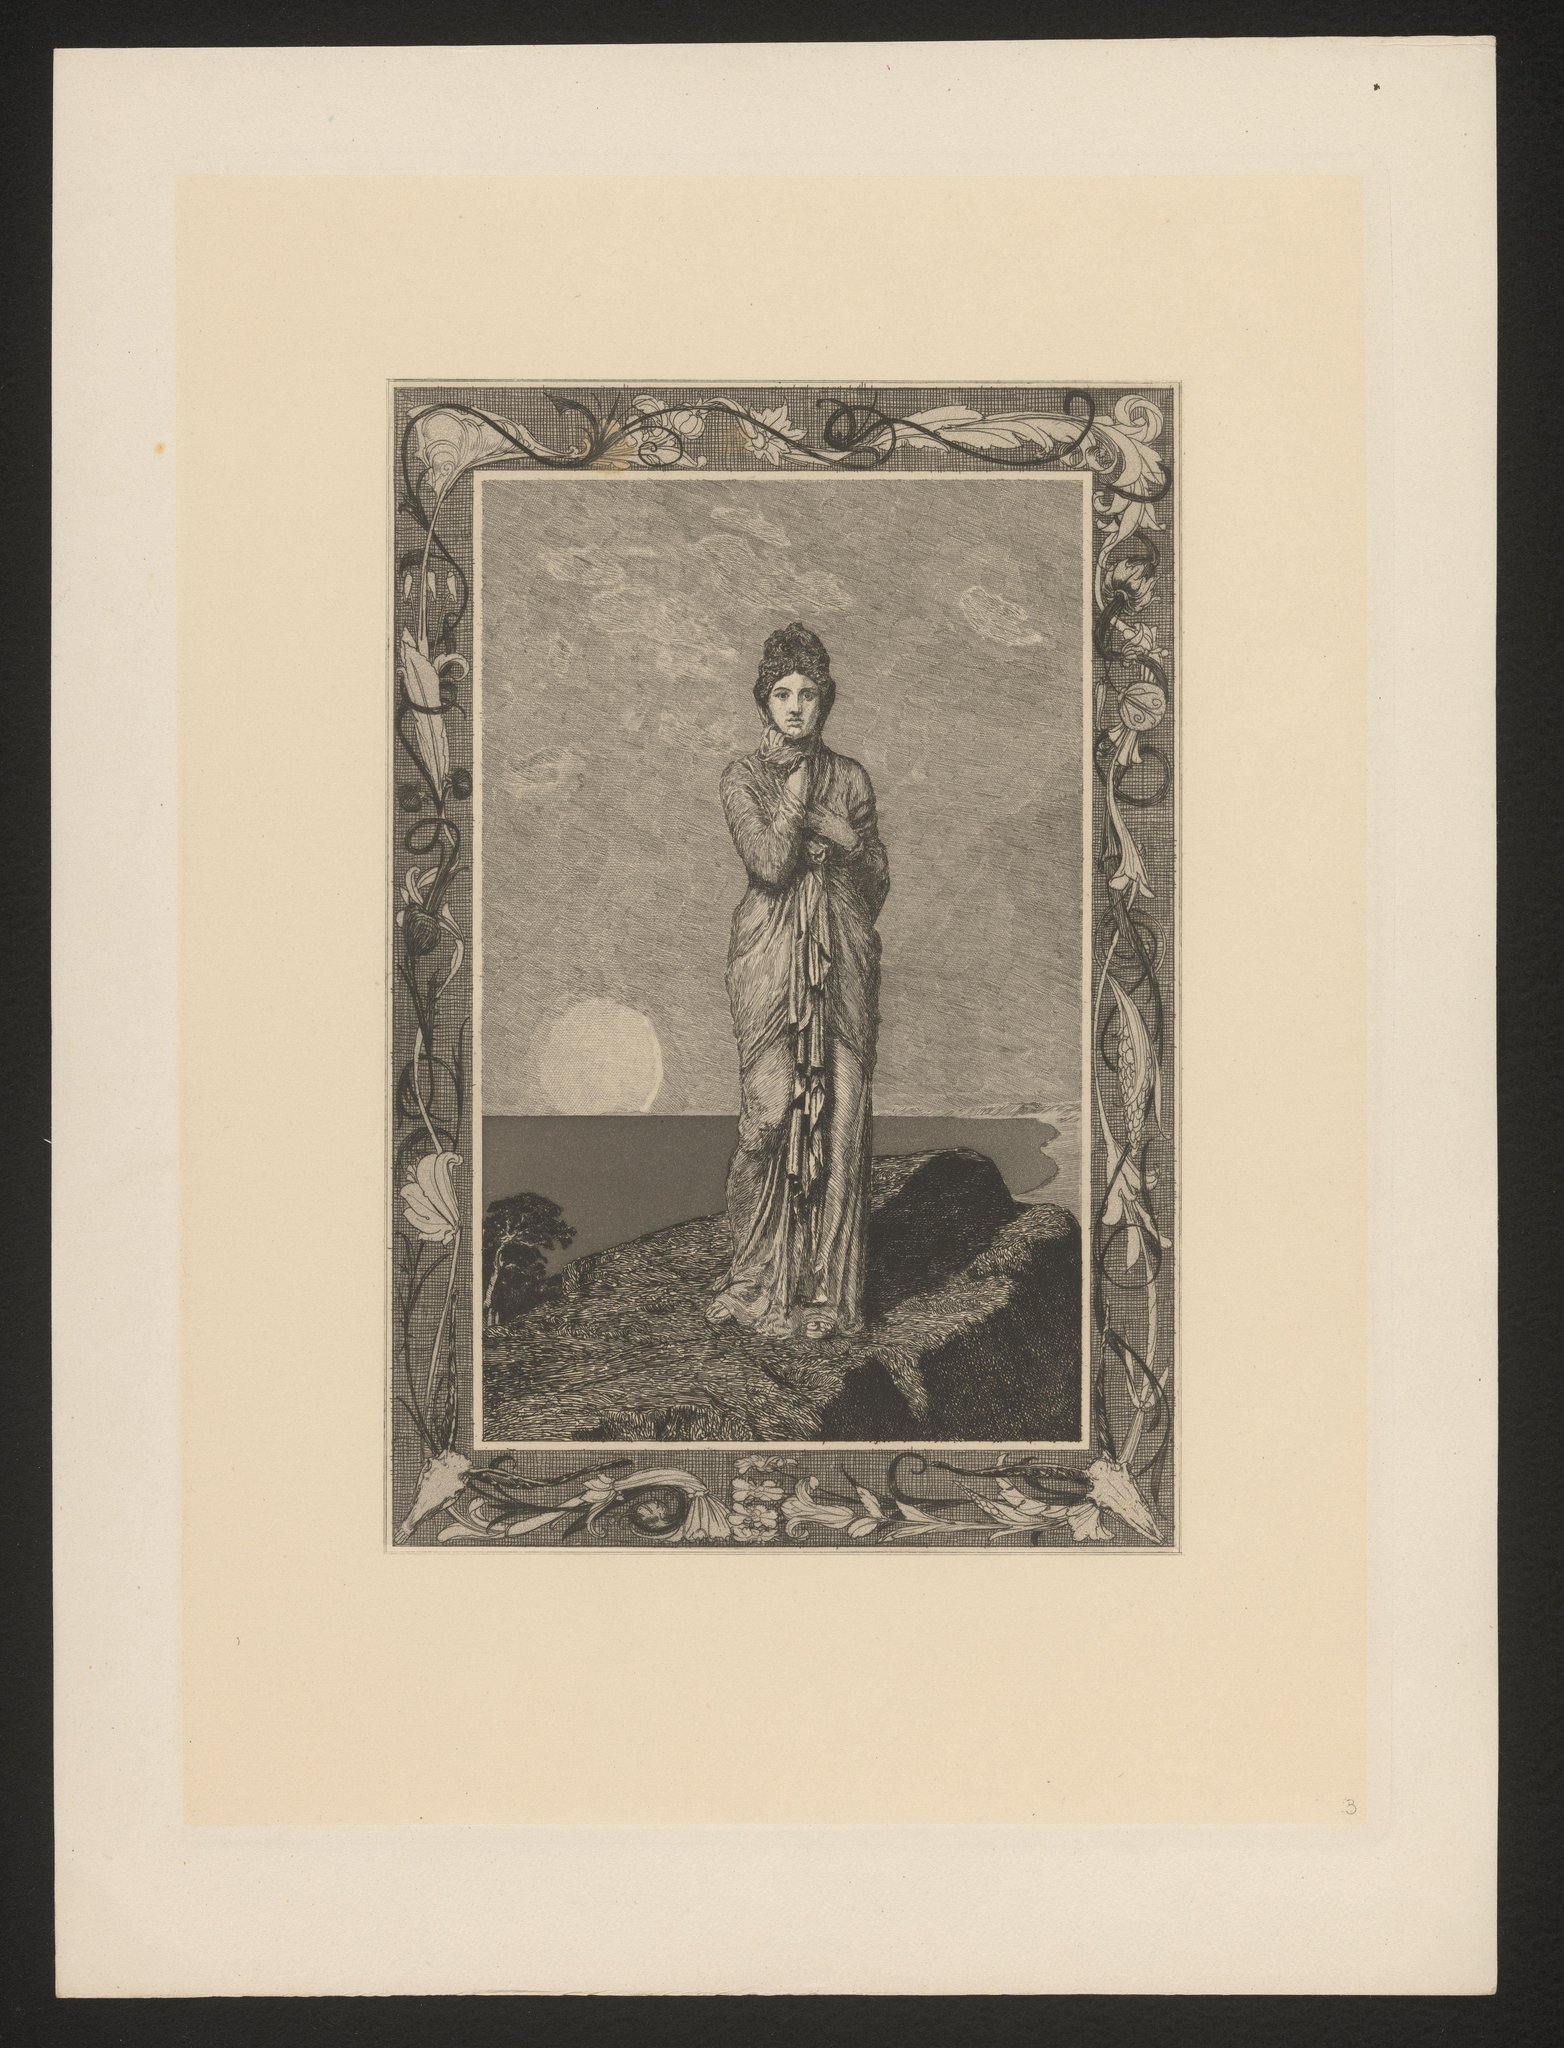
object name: print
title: Etsen bij Amor en Psyche van Apuleius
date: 1880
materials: paper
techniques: aquatint, etching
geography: nuremberg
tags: story of cupid and psyche (apuleius, 'metamorphoses' (golden ass) iv 28 - vi 25)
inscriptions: collector's mark: Lugt 2228